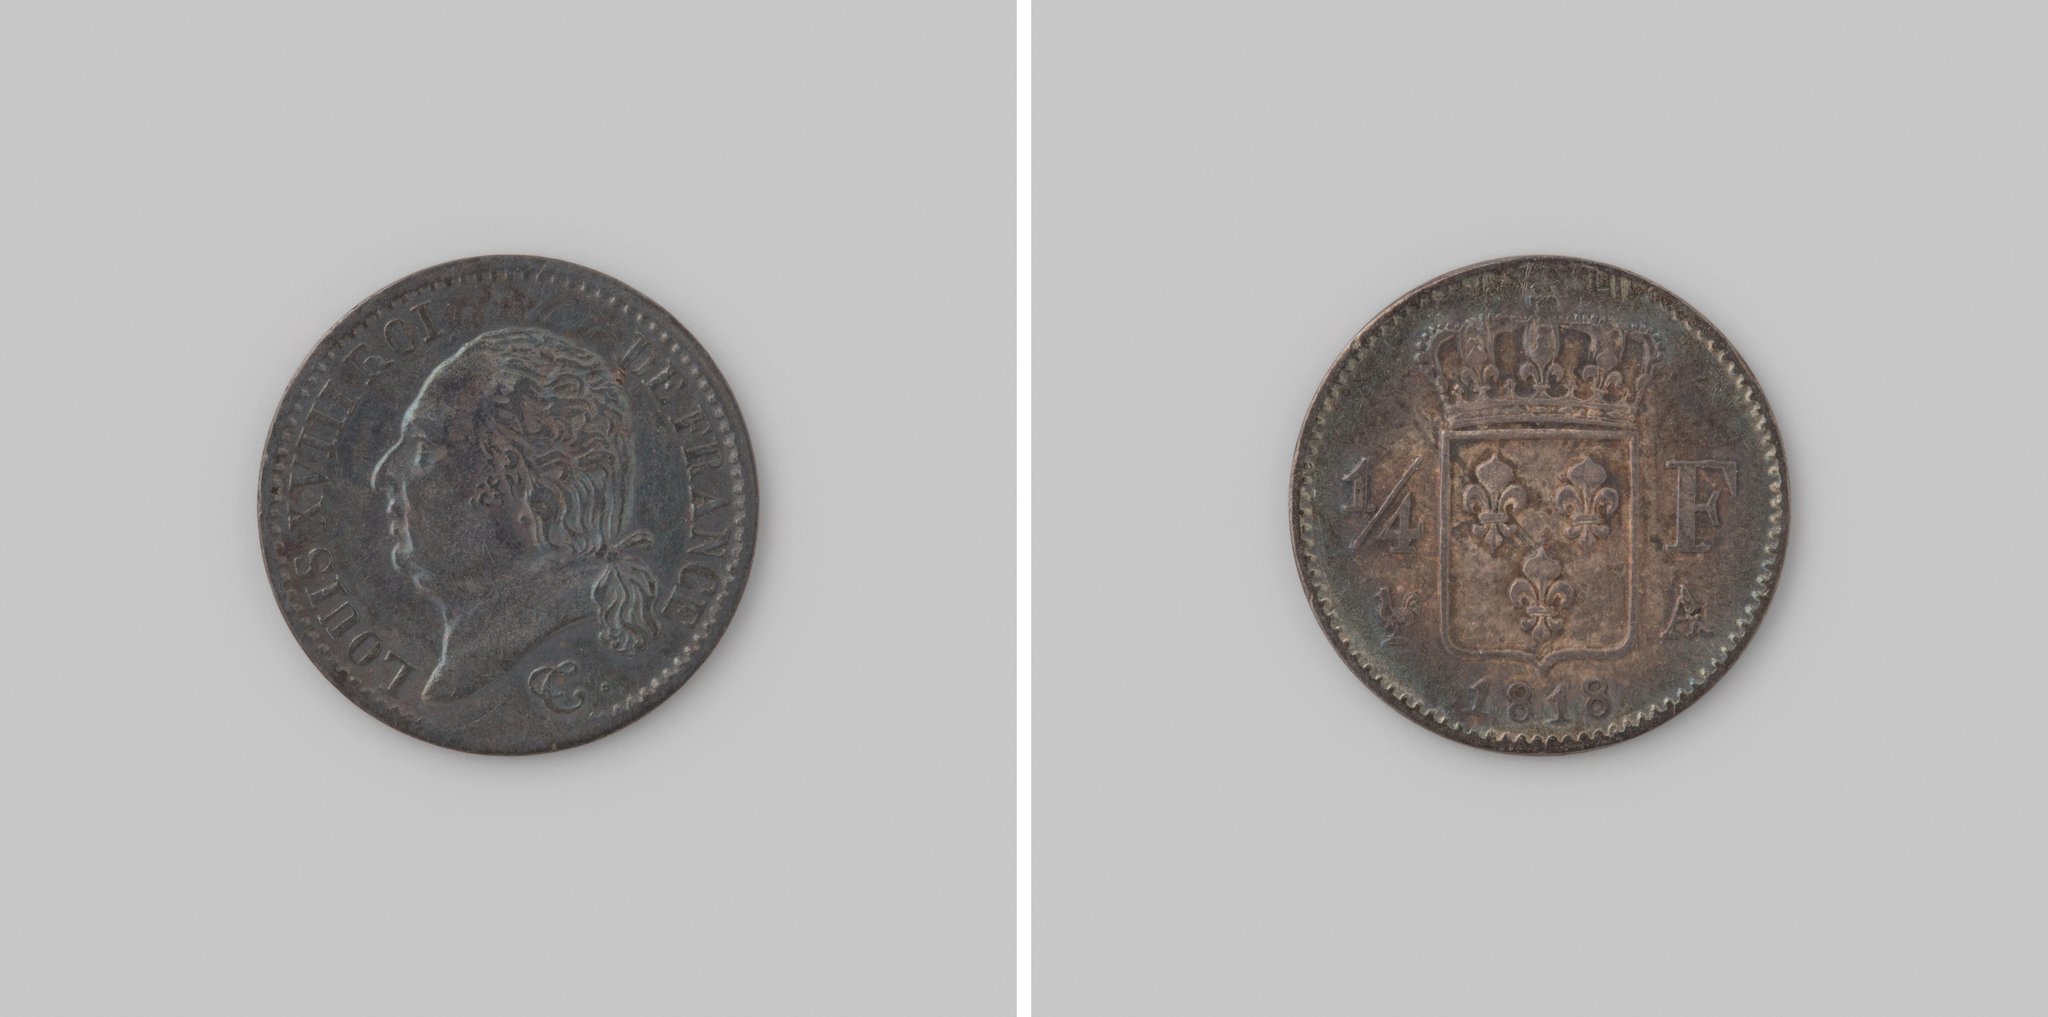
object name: coin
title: Koninkrijk Frankrijk, Lodewijk XVIII, 1/4 franc, 1818 A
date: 1818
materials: silver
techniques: striking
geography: paris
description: Zilveren munt. Voorzijde: hoofd van de koning naar links. Keerzijde: binnen twee samengebonden lauriertakken tussen waarde-aanduiding en letter A [=Parijs] gekroond wapenschild. Onderaan jaartal. Gladde rand.